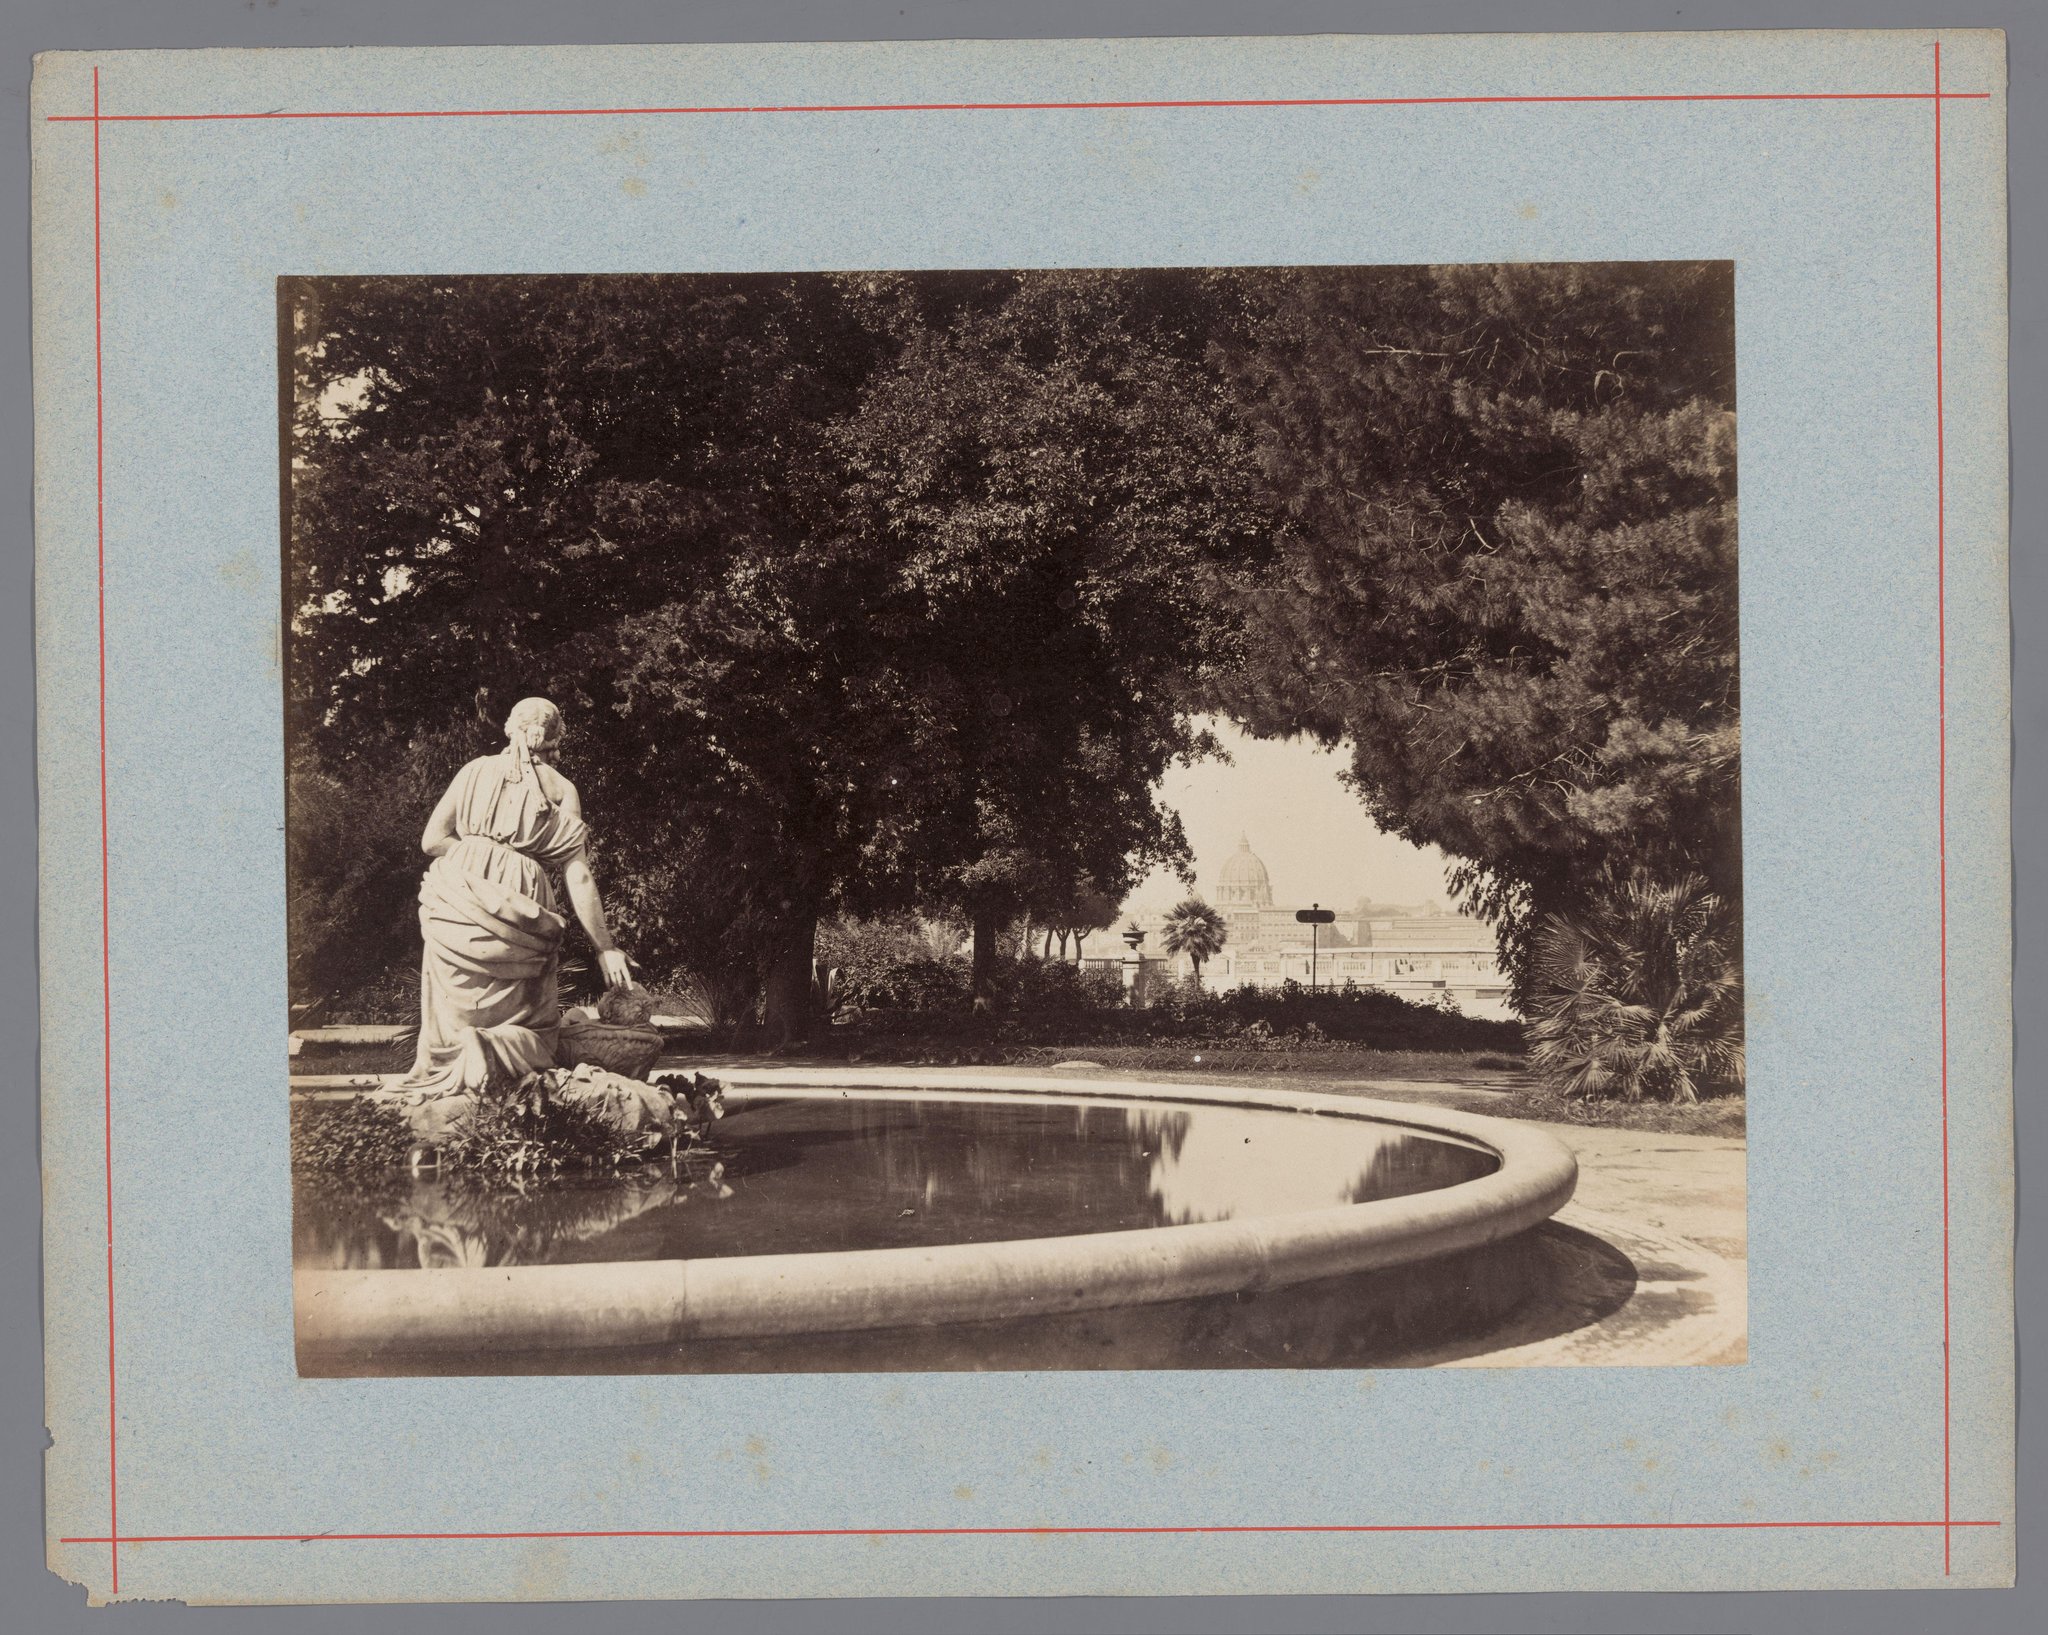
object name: photograph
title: Vue prise de Pincia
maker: Anonymous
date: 1851-1900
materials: cardboard, paper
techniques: albumen print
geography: rome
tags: parts of church exterior and annexes: dome, garden pond, prospect of city, town panorama, silhouette of city, rome